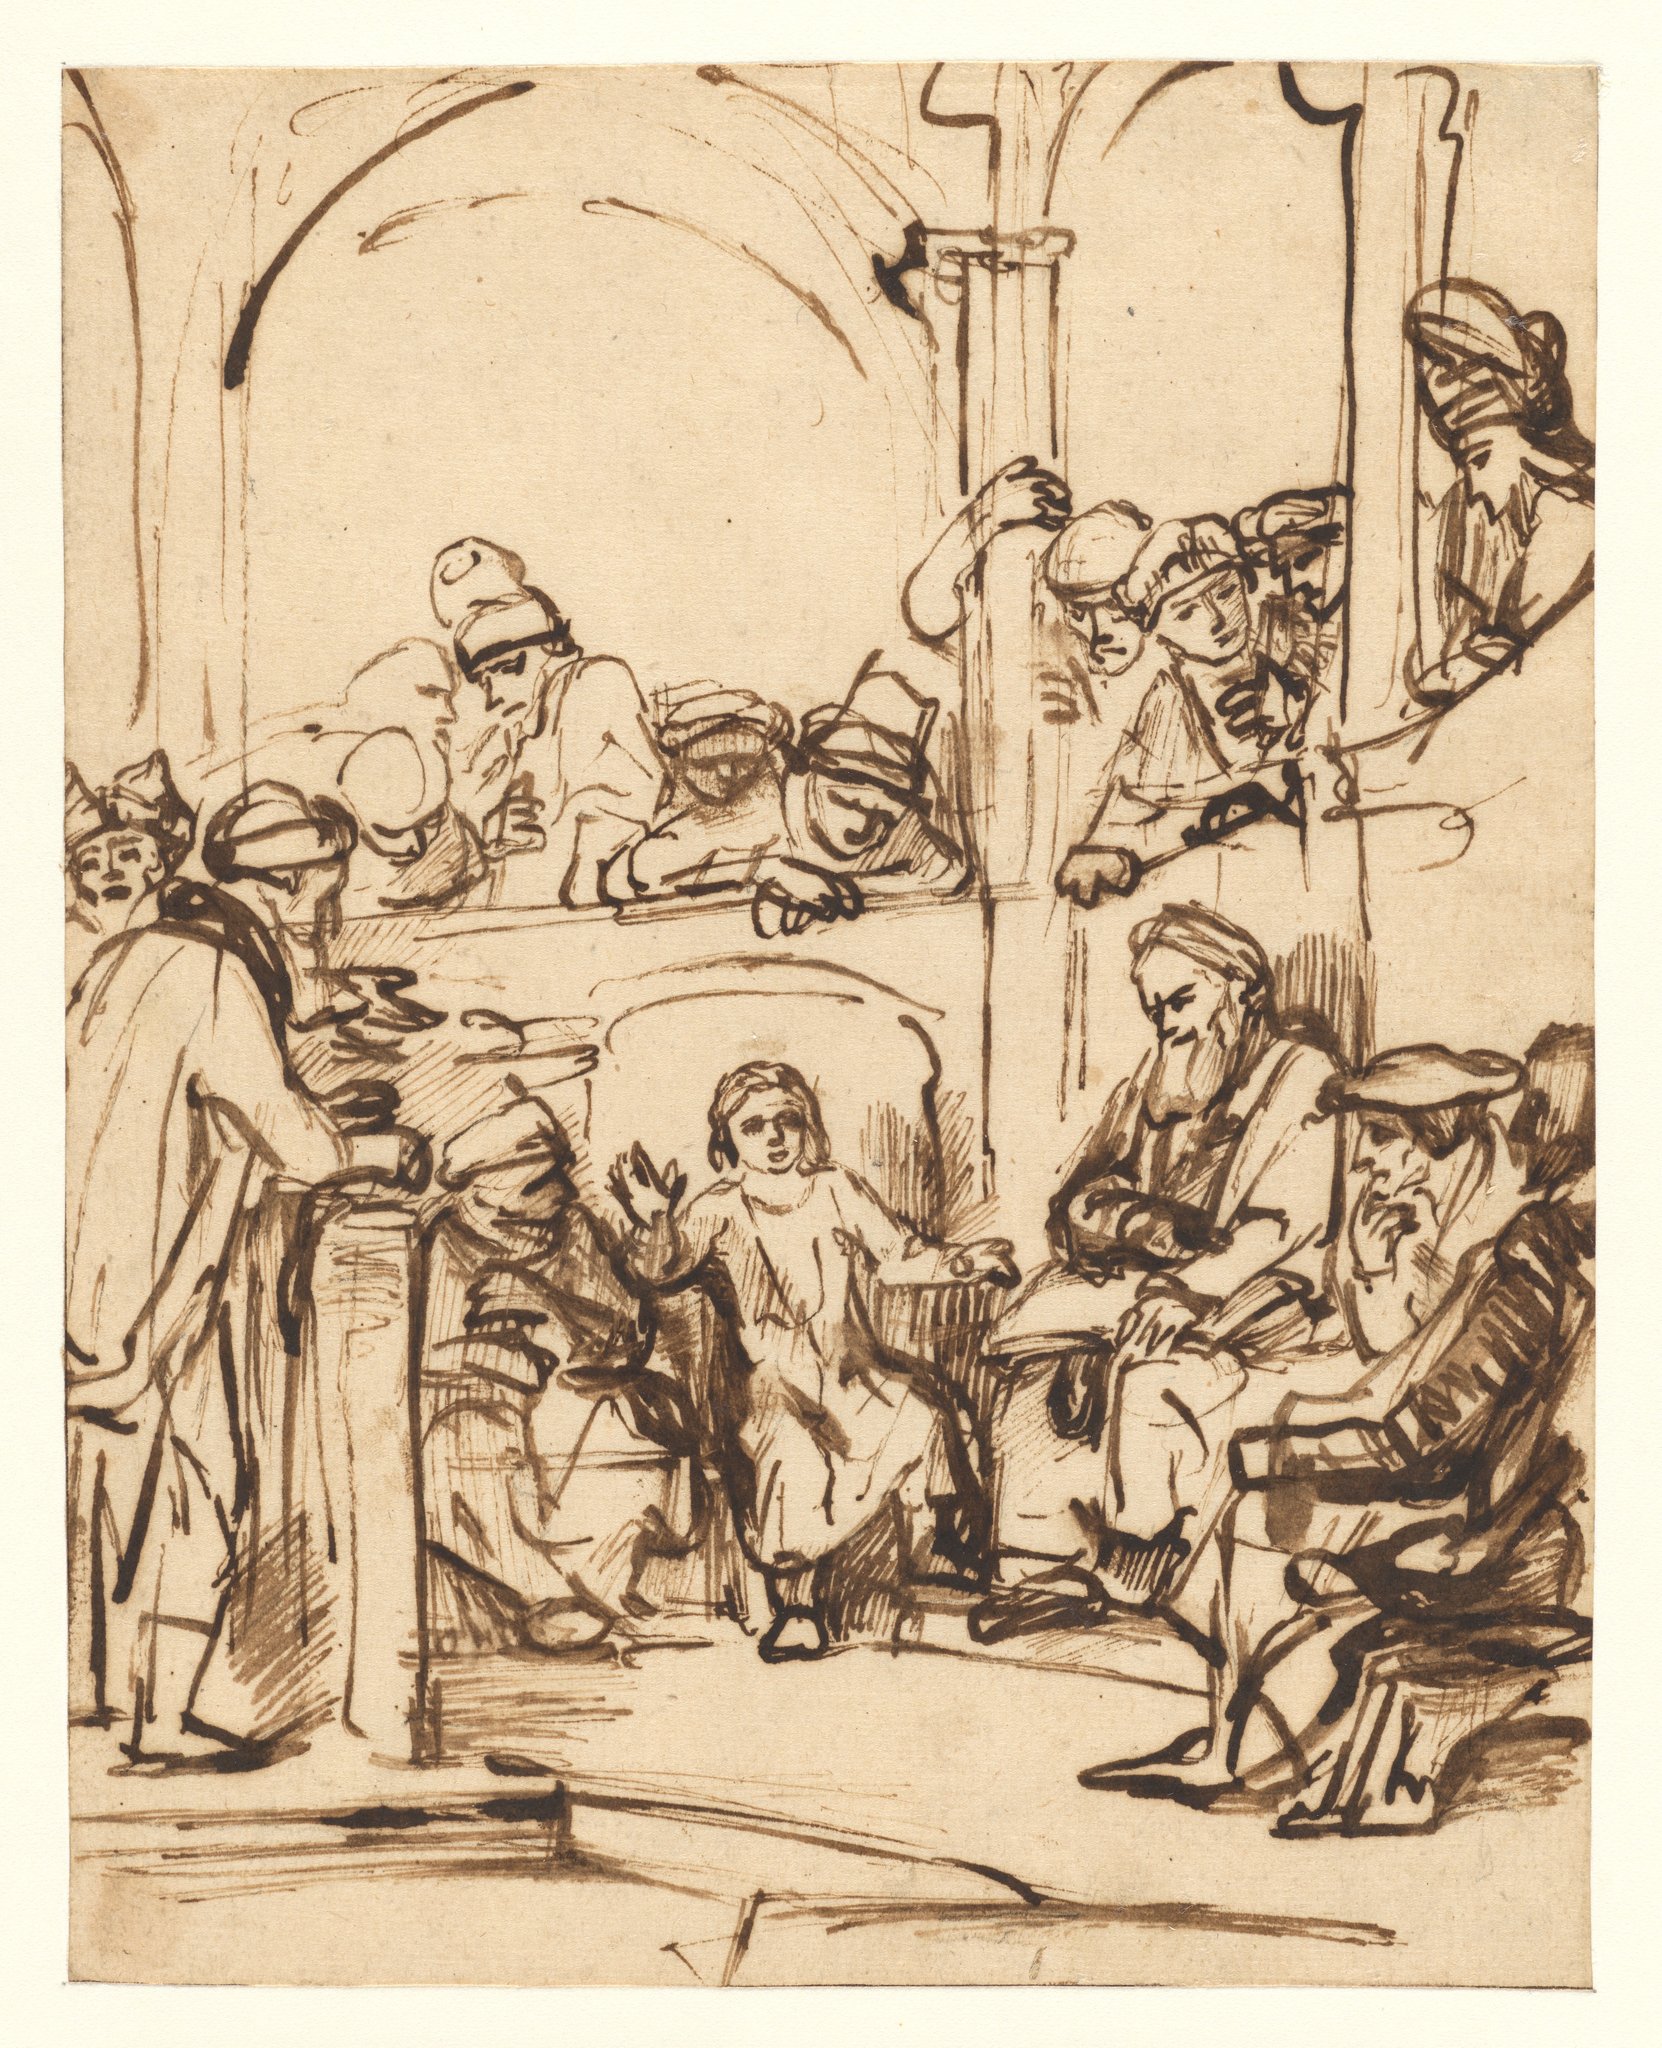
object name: drawing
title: Christ among the Doctors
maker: nicolaes maes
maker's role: former attribution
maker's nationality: dutch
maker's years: 1634-1693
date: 1652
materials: ink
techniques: brush, pen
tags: men,christ,doctors